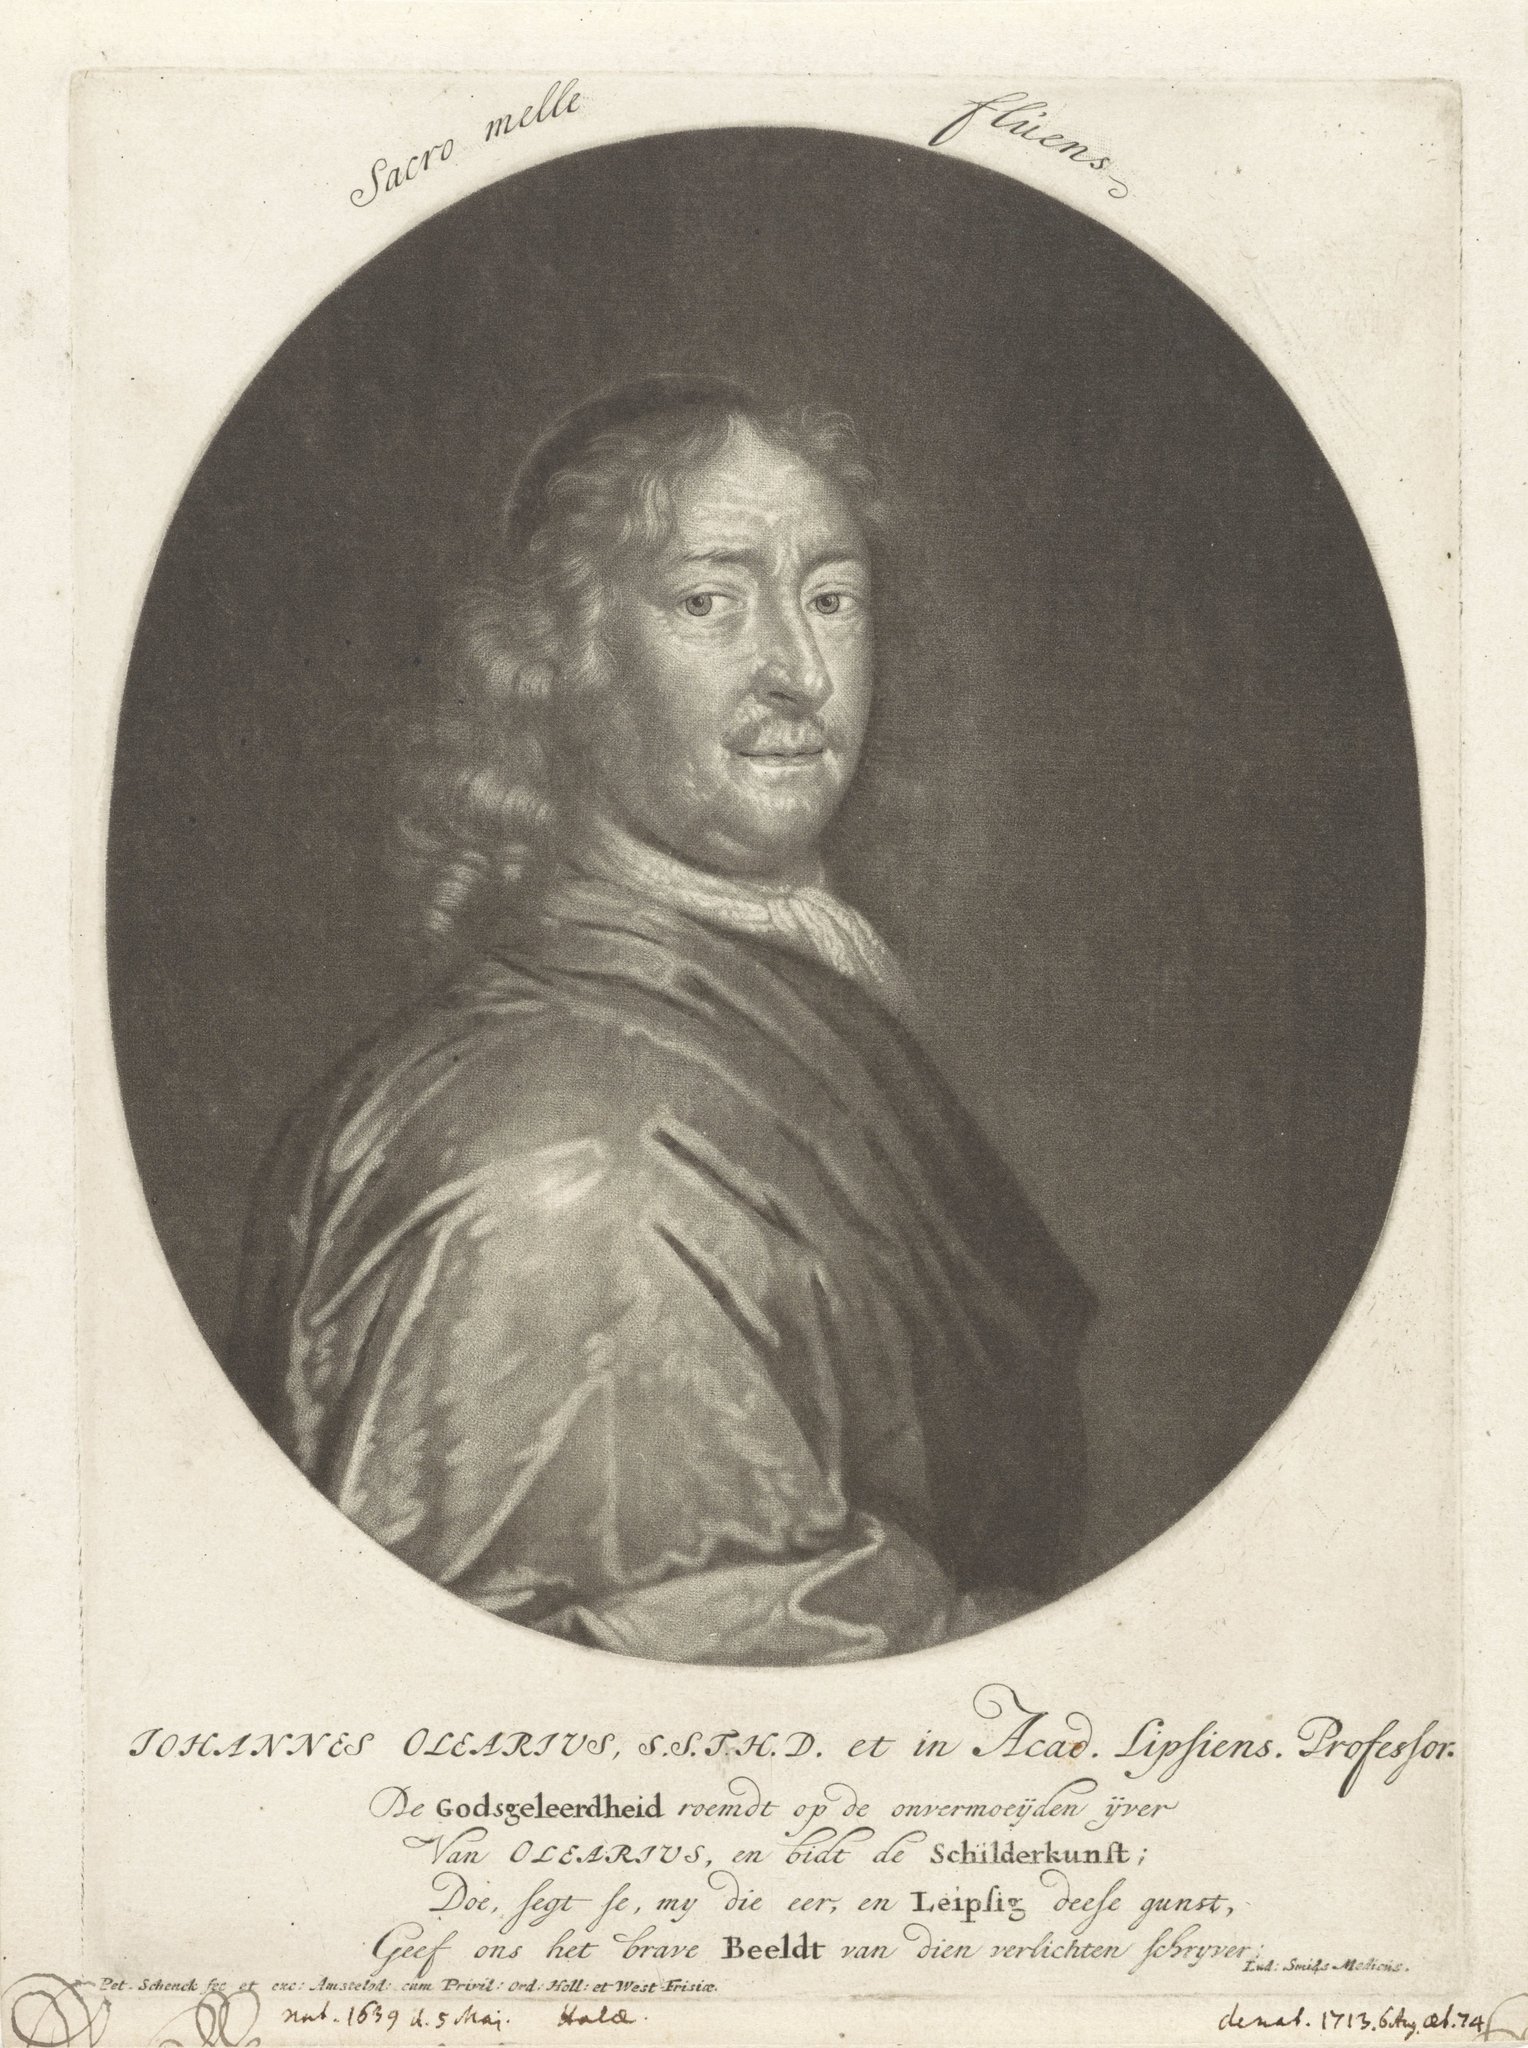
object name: print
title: Portret van de theoloog Johann Olearius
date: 1670-1713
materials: paper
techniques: engraving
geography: amsterdam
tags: johannes olearius, theologian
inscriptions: collector's mark: Lugt 2228